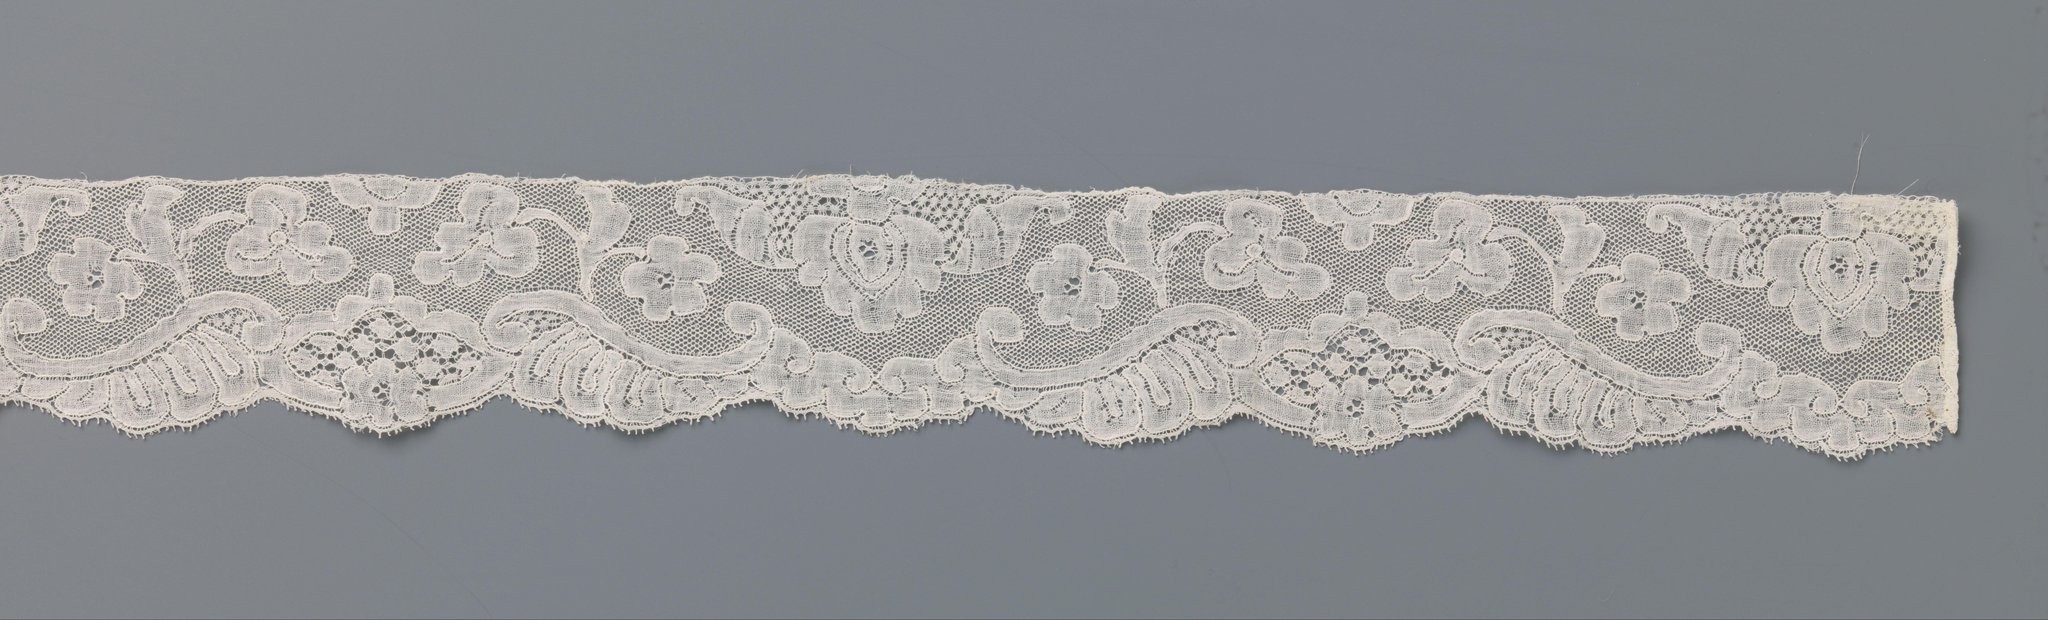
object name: strip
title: Strook kant met drielobbig cartouche en afhangende bloem met druppelvormig hart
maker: Anonymous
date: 1740-1760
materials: linen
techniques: lace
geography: mechelen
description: Strook naturelkleurige kloskant: Mechelse kant. Het zich herhalende patroon bestaat uit twee in elkaar overlopende symmetrische composities. De ene compositie bestaat uit een drielobbig cartouche, dat langs de onderzijde ligt en links en rechts geflankeerd wordt door een langgerekt s-voluut met vijf lobben aan de onderkant. Uit de s-voluten ontspringt een zich splitsende tak met één blad en twee bloemen. De andere compositie bestaat uit een vanaf de bovenzijde afhangende bloem met een druppelvormig hart, tussen twee bladeren. De motieven zijn met elkaar verbonden door een fijne maasgrond. De motieven zijn gemaakt in linnenslag met weinig uitsparingen, maar met opengewerkte randjes. Rond de motieven zijn met iets dikkere en glimmende draad contourlijnen aangebracht. Enkele verschillende siergronden zijn toegepast, waaronder een sneeuwvlokkengrond, in onder andere het cartouche en tussen de bladeren. De flauw geschulpte onderzijde komt voort uit het patroon en is afgewerkt met picots. De bovenzijde is recht afgewerkt.